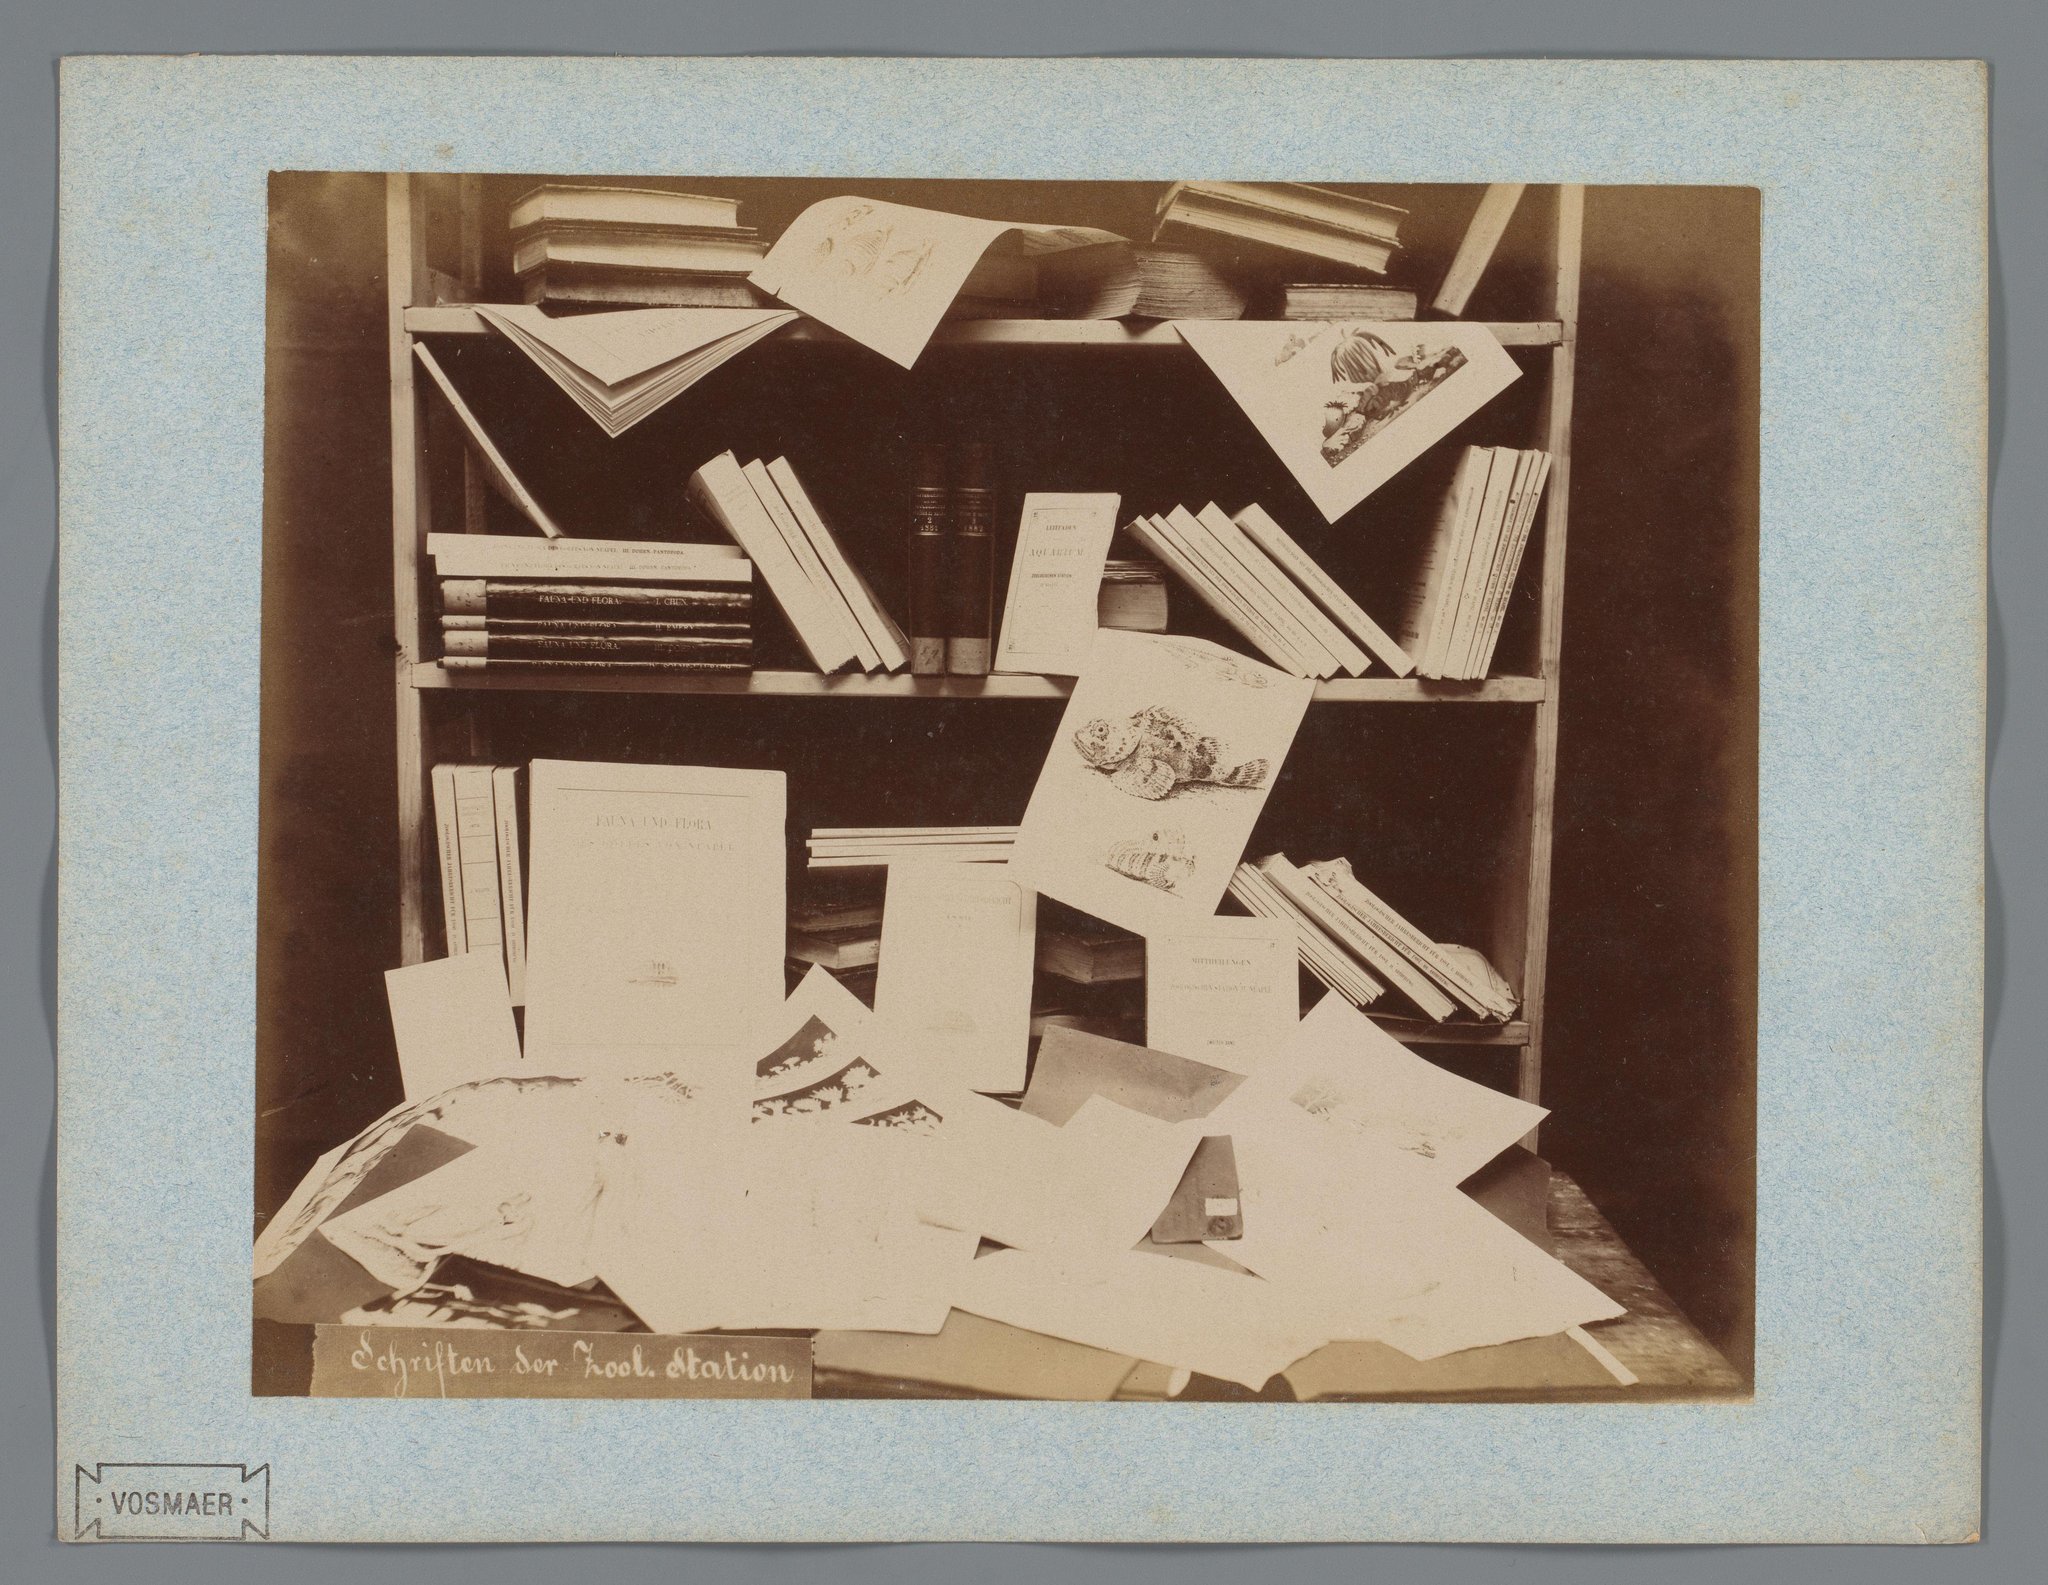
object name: photograph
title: Schriften der Zool. Station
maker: Anonymous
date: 1874-1900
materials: cardboard, paper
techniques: albumen print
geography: naples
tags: print, e.g.: engraving, etching, lithograph, book, zoology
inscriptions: collector's mark: ‘VOSMAER’